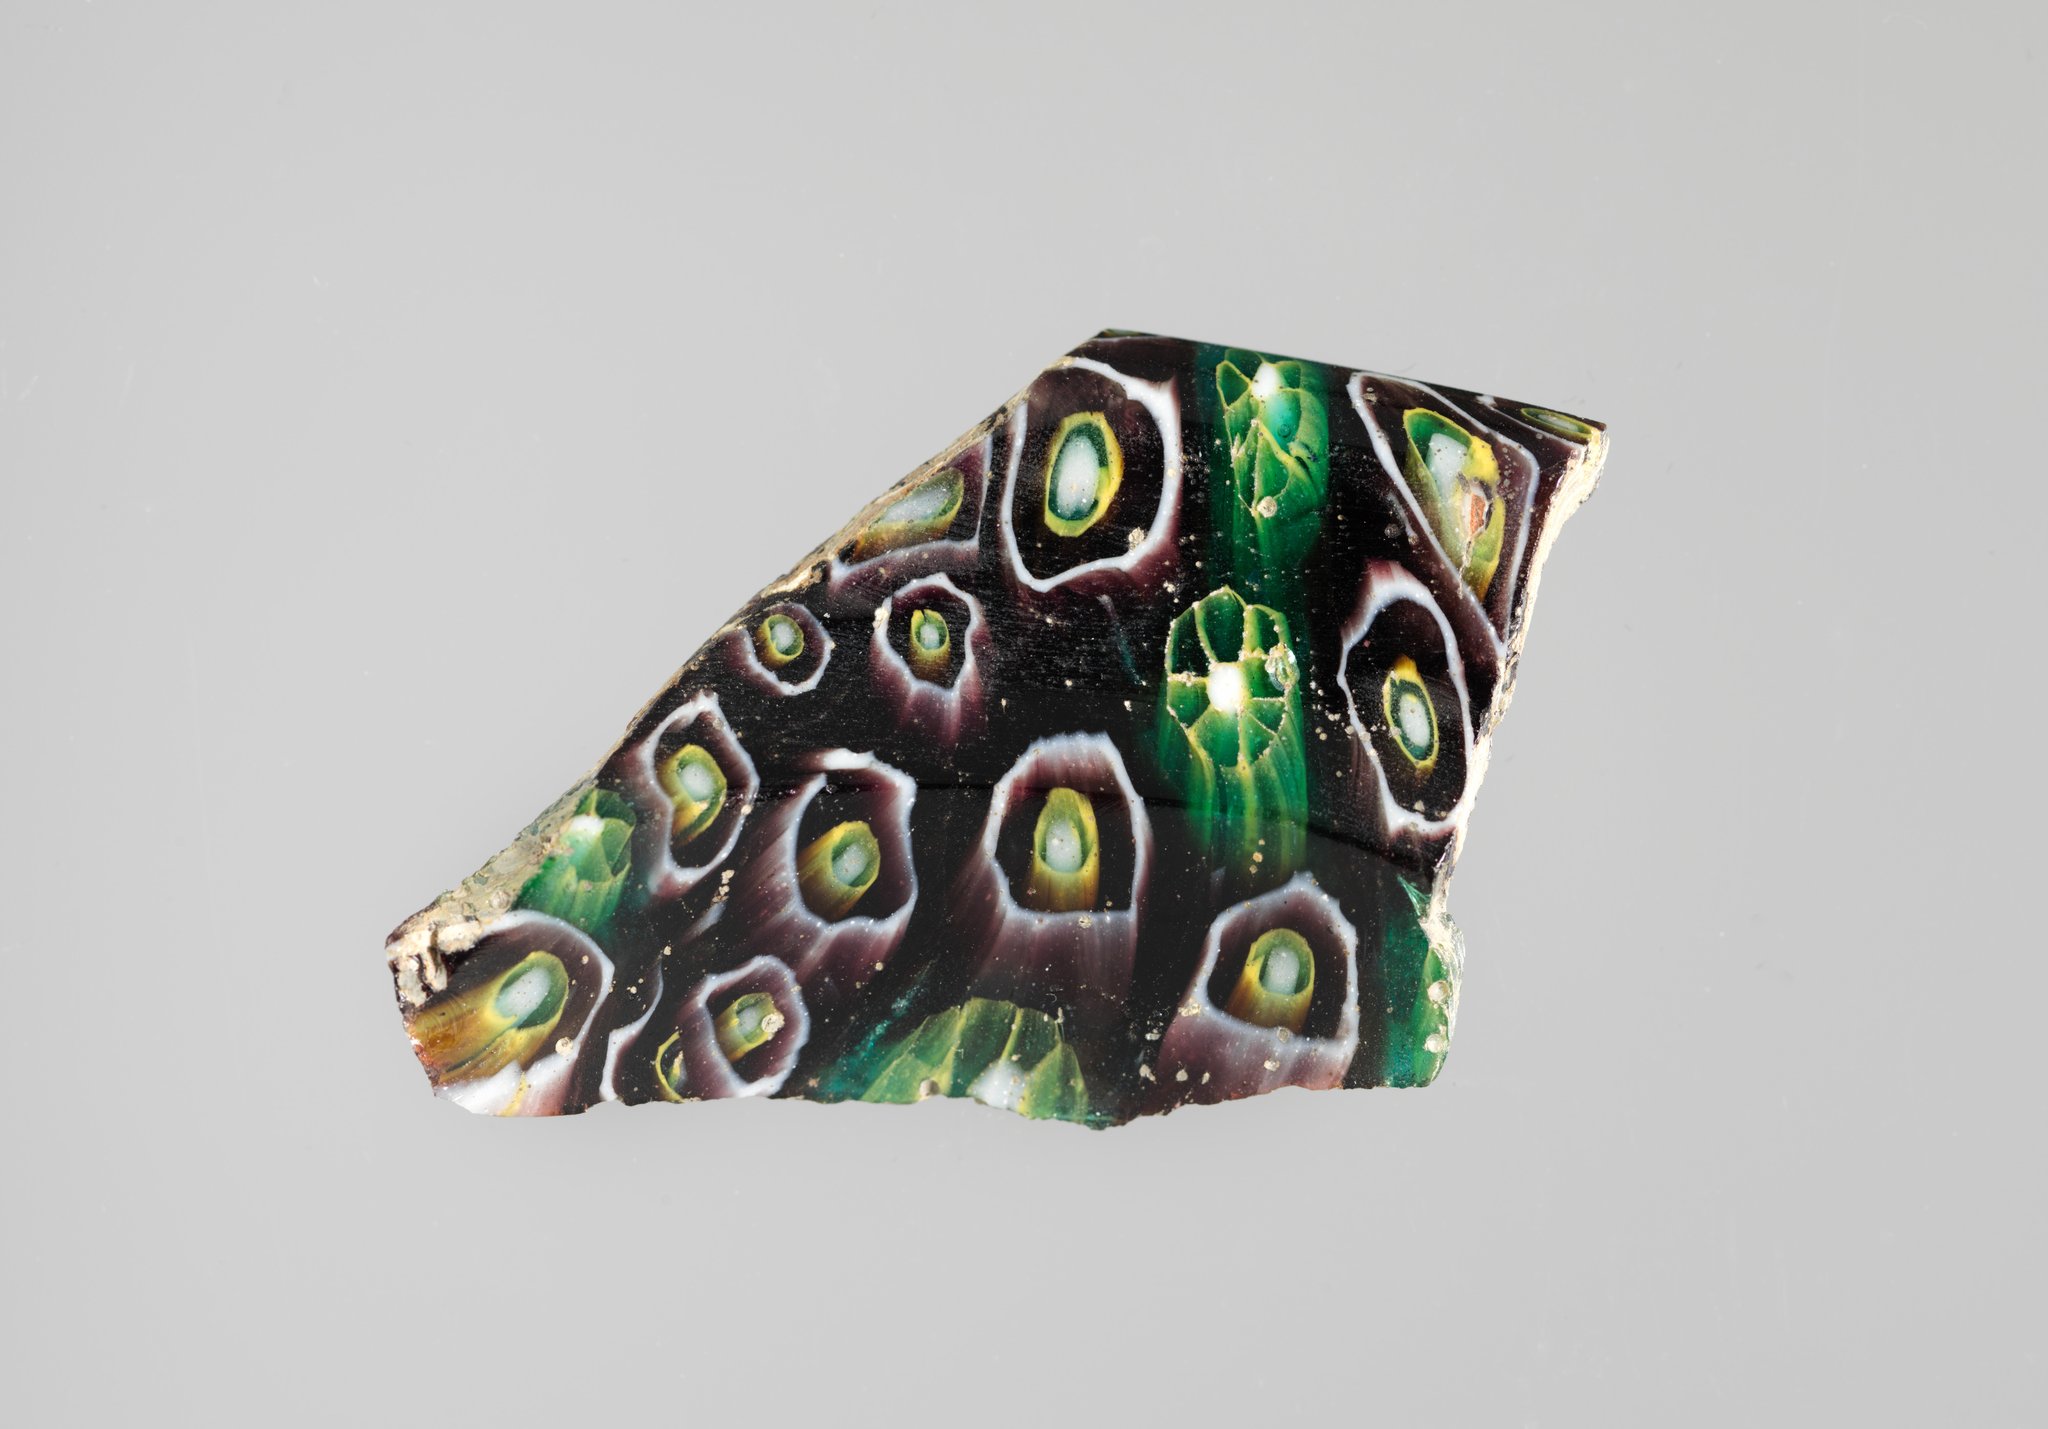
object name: fragment, mosaic bowl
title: Glass mosaic carinated bowl fragment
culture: roman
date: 34 BCE-33 CE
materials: glass